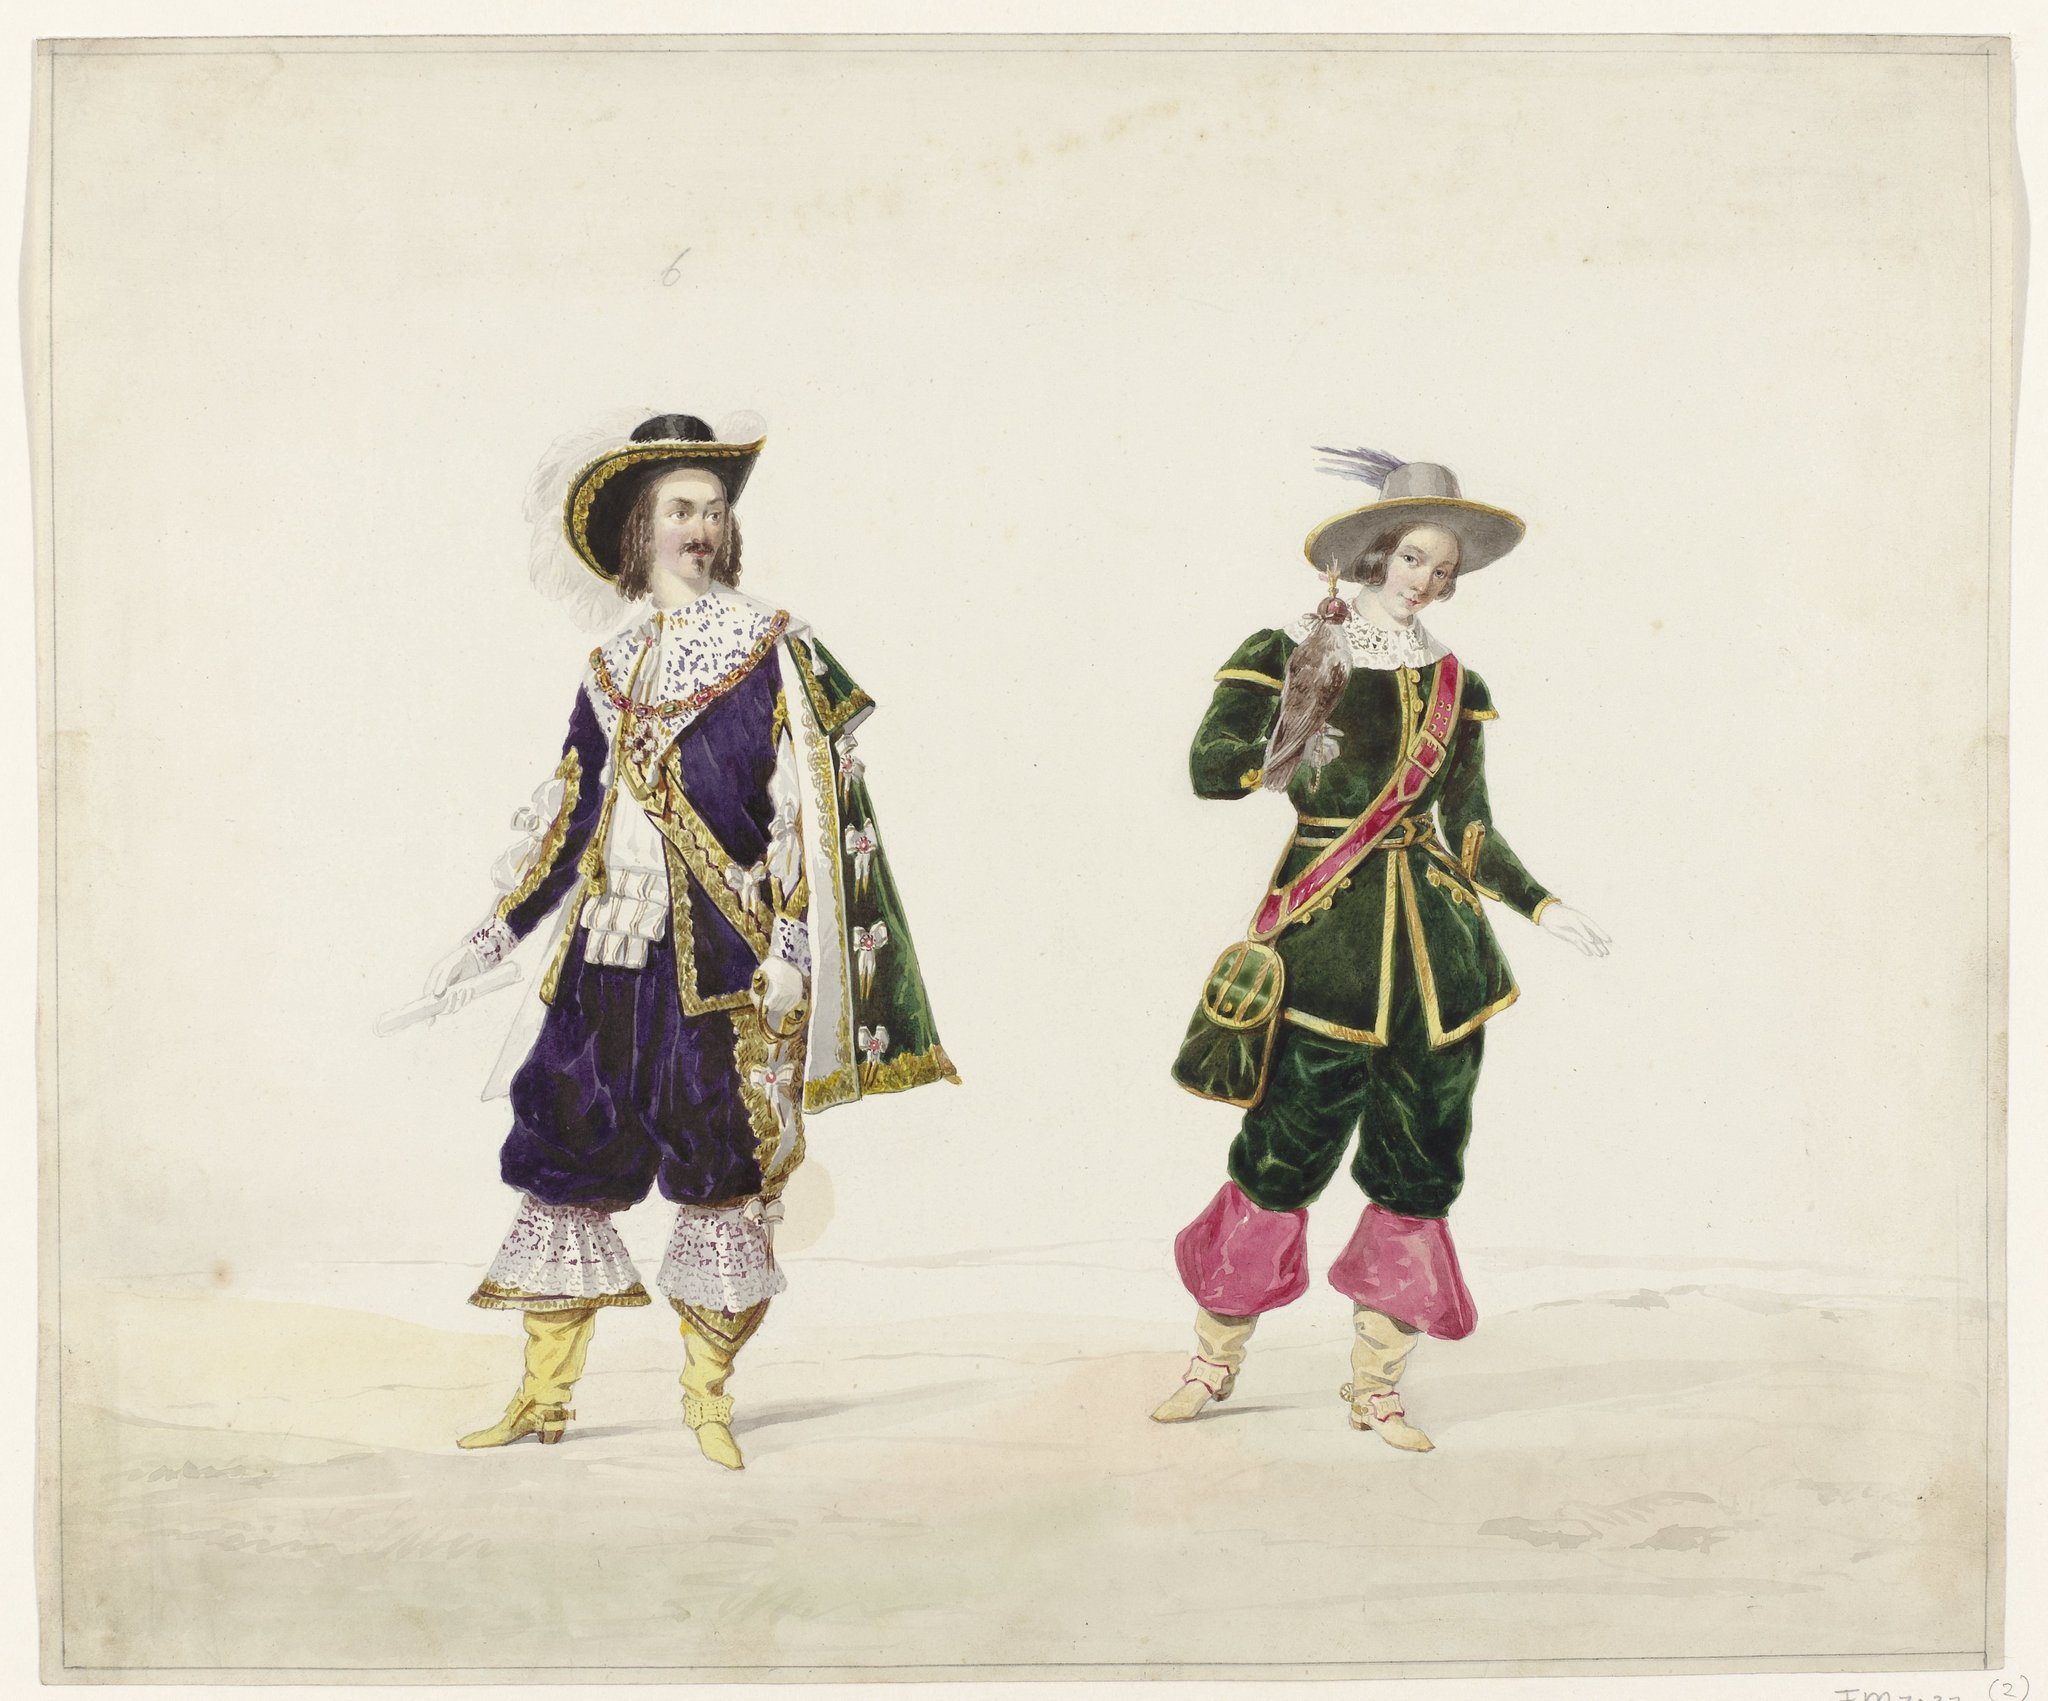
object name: watercolor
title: Zes aquarellen van historische kostuums voor het gekostumeerde bal in 1841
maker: huib van hove bz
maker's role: painter, print maker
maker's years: 1814-1867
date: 1841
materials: paper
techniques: drawing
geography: netherlands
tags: the hague, anna paulowna romanowa, william ii of the netherlands, predatory birds: falcon, historical costume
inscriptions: collector's mark: Lugt 2228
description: Twee mannen in historisch kostuum. De man rechts als valkenier. Kostuums gedragen op het gekostumeerde bal gehouden te Den Haag op 17 en 19 februari 1841 bij het 25-jarig huwelijk van koning Willem II en Anna Paulowna. Platen naar sommige van deze voorstellingen komen voor in een album over dit bal.